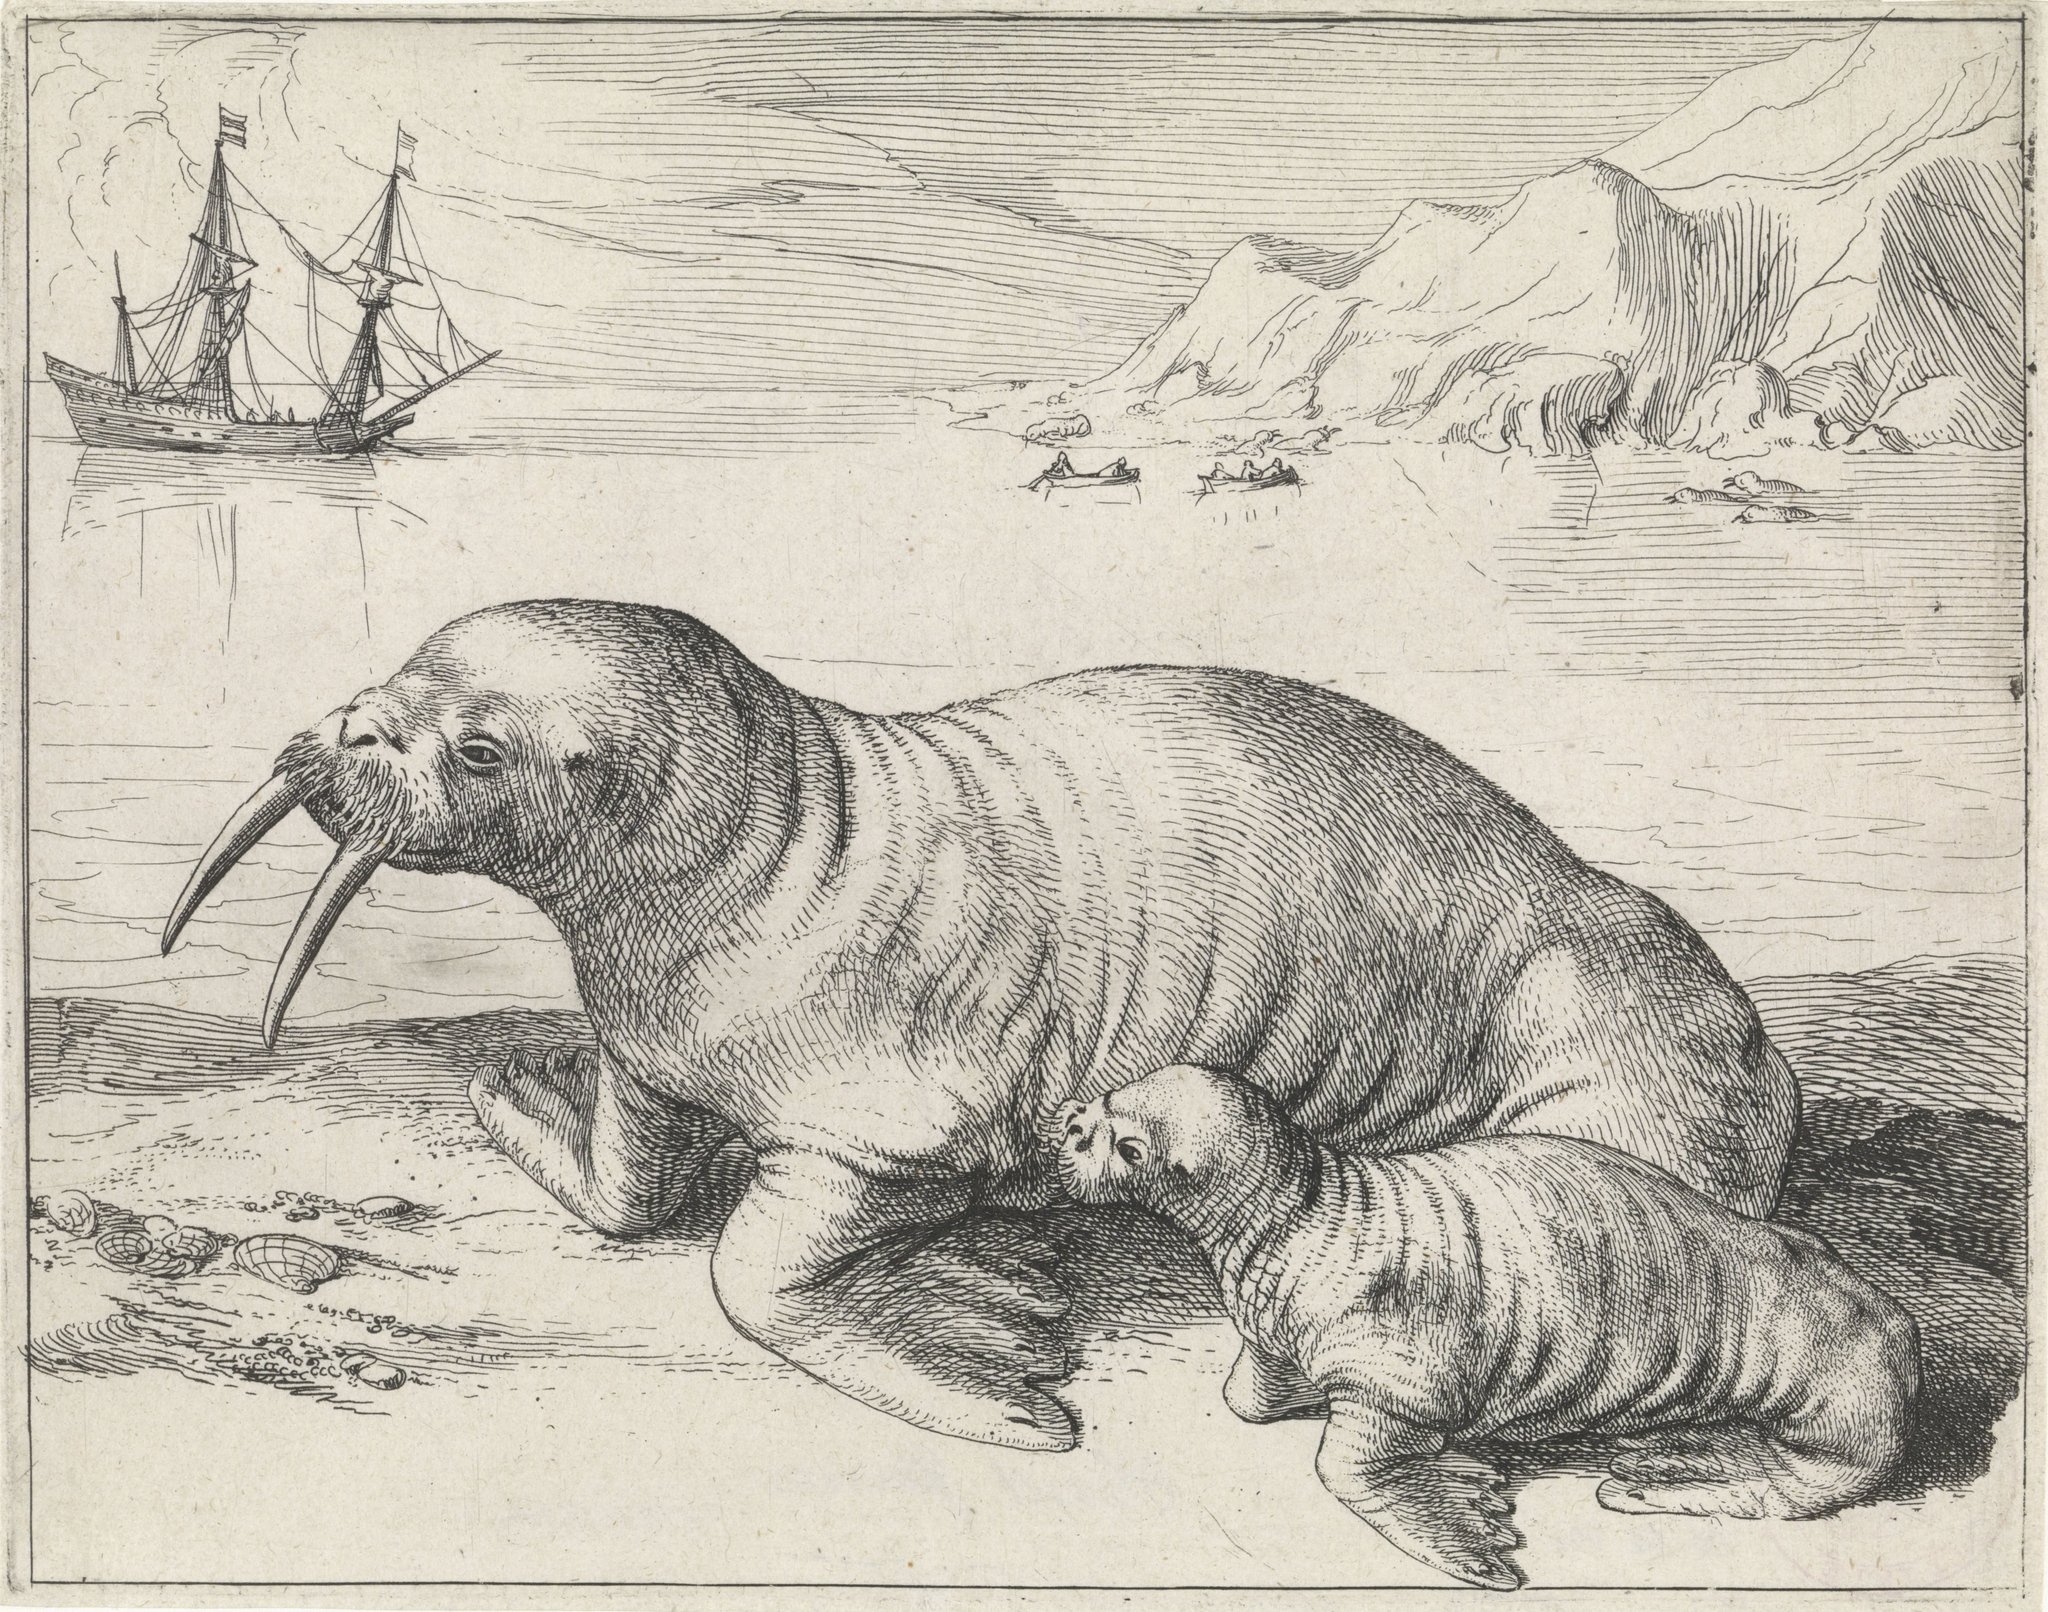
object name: print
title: Walrus bij Spitsbergen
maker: hessel gerritsz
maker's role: draughtsman, print maker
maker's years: 1581-1632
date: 1591-1632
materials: paper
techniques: etching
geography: amsterdam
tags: swimming mammals: walrus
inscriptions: collector's mark: Lugt 240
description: Een walrus en haar jong, nabij Spitsbergen. Op de achtergrond een schip en enkele roeiboten.